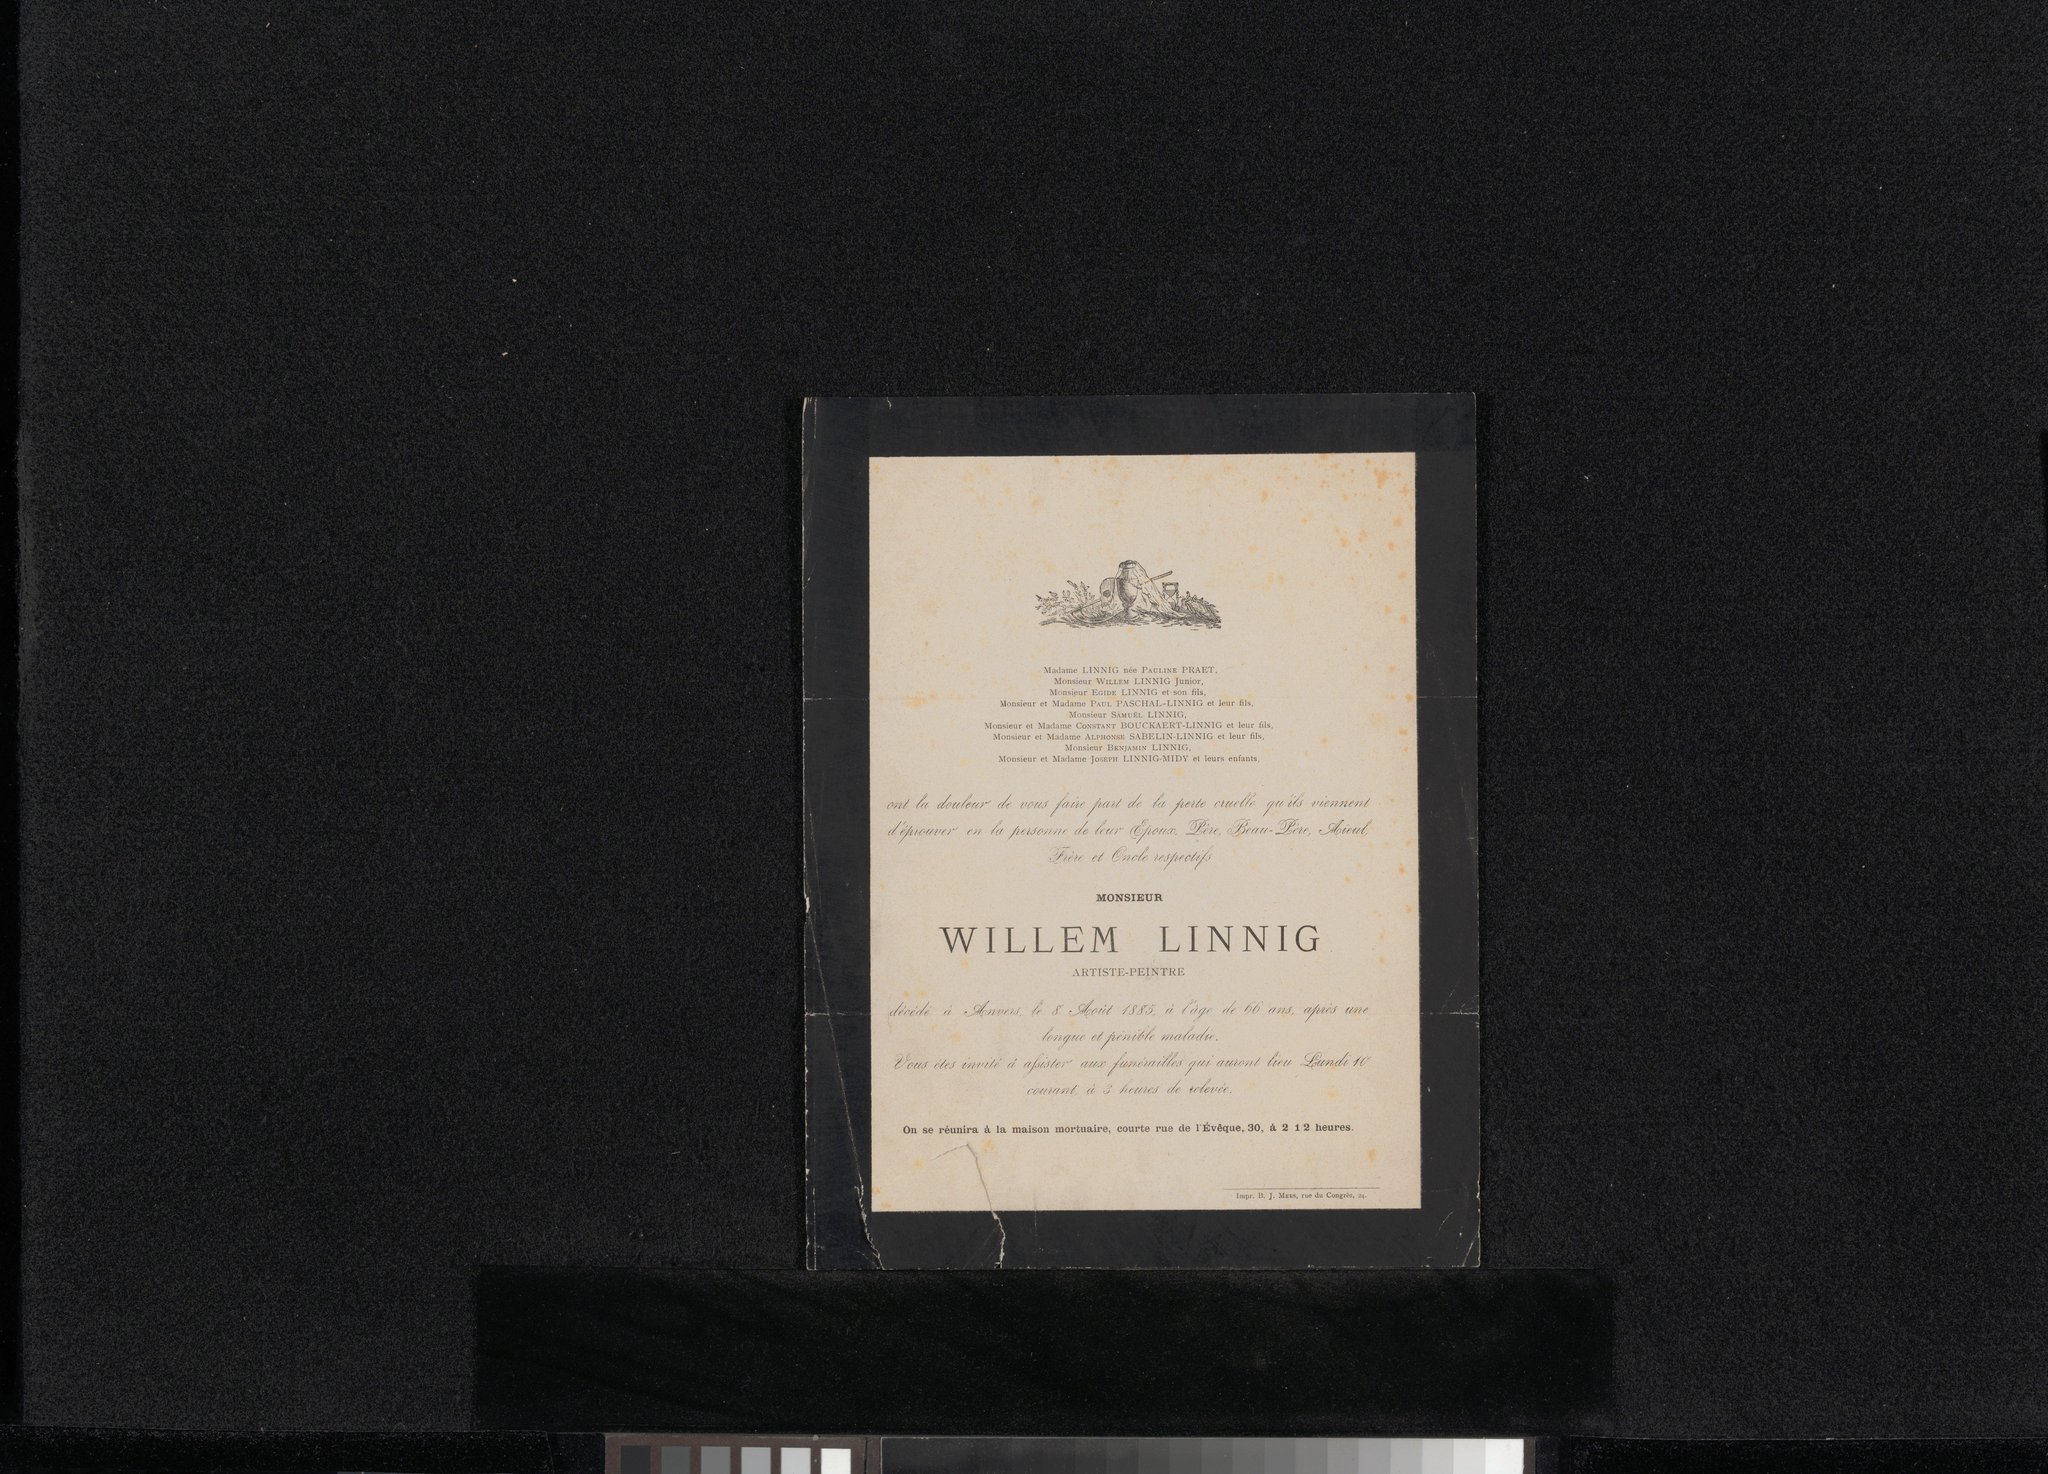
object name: overlijdensbericht, overlijdensadvertentie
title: Overlijdensbericht betreffende Willem Linnig (I)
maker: b.j. mees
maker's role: printer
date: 1885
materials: paper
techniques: printing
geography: antwerp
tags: antwerp, print maker, willem linnig (i)